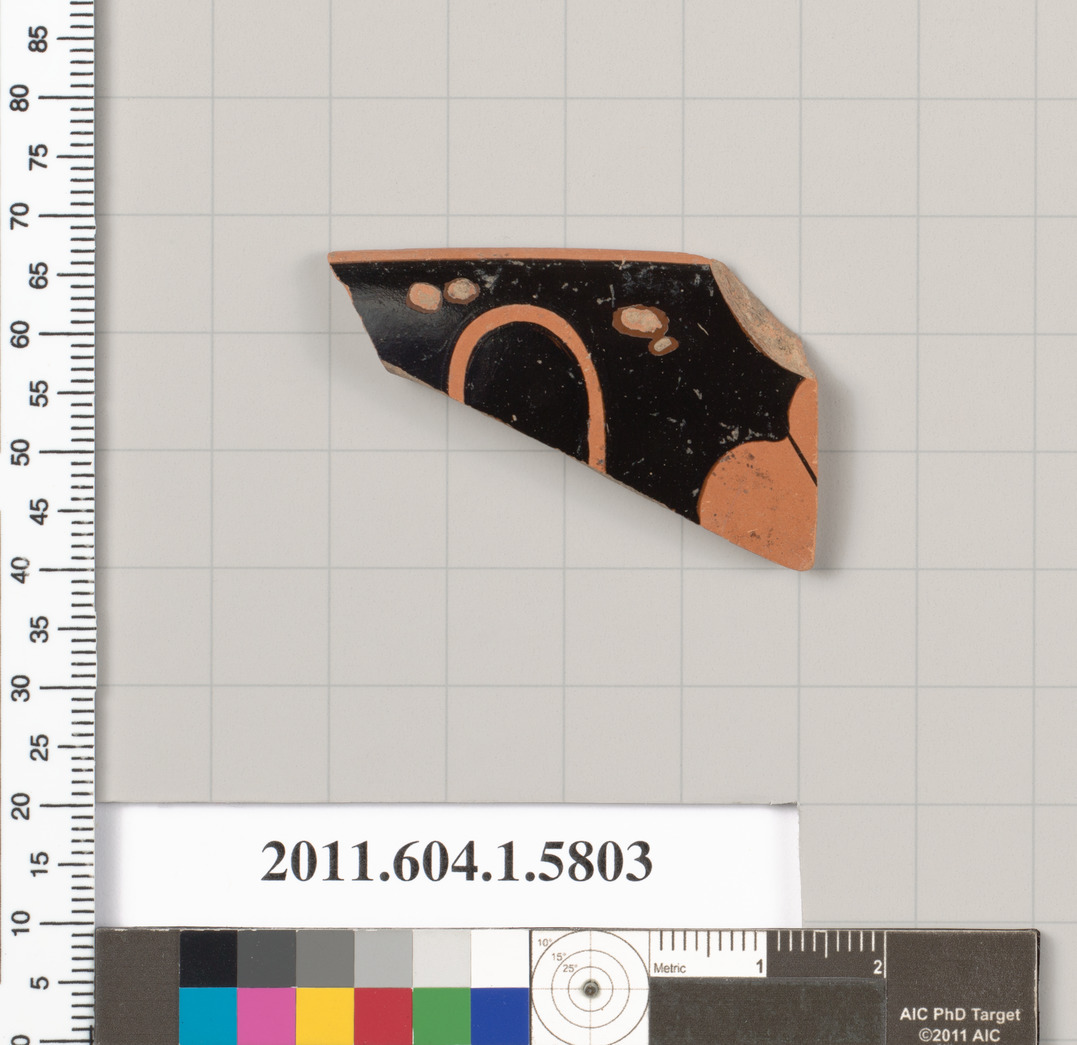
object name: kylix fragment, eye cup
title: Terracotta fragment of a kylix: eye-cup (drinking cup)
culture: greek, attic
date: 520-510 BCE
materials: terracotta